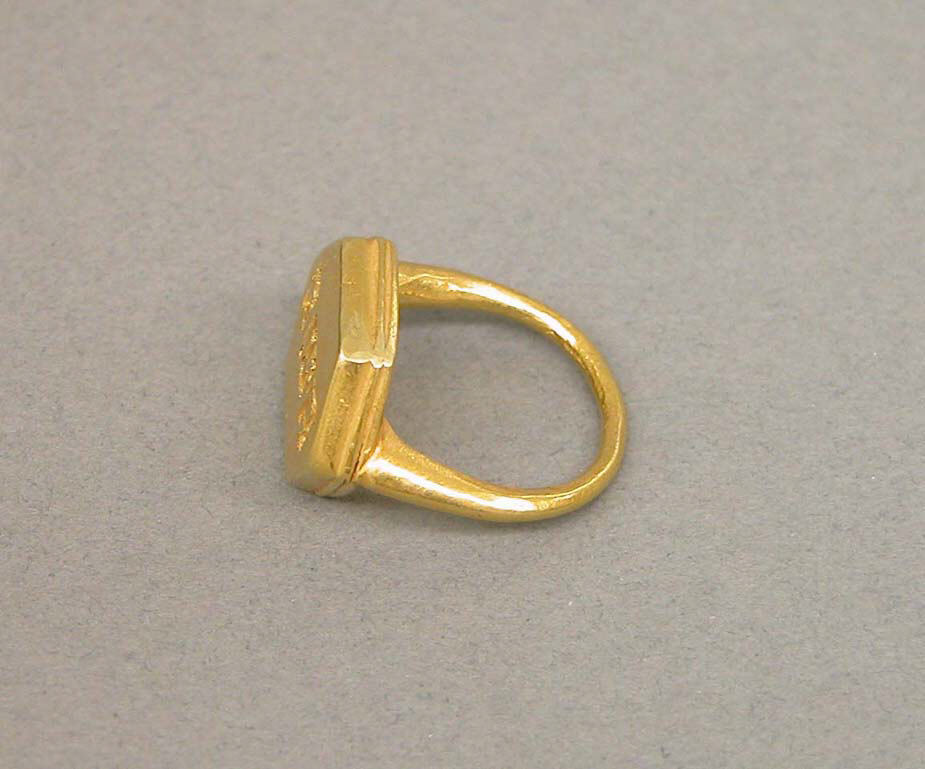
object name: ring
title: Ring with Plain Hexagonal Bezel and "Java Kuno"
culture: indonesian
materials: gold